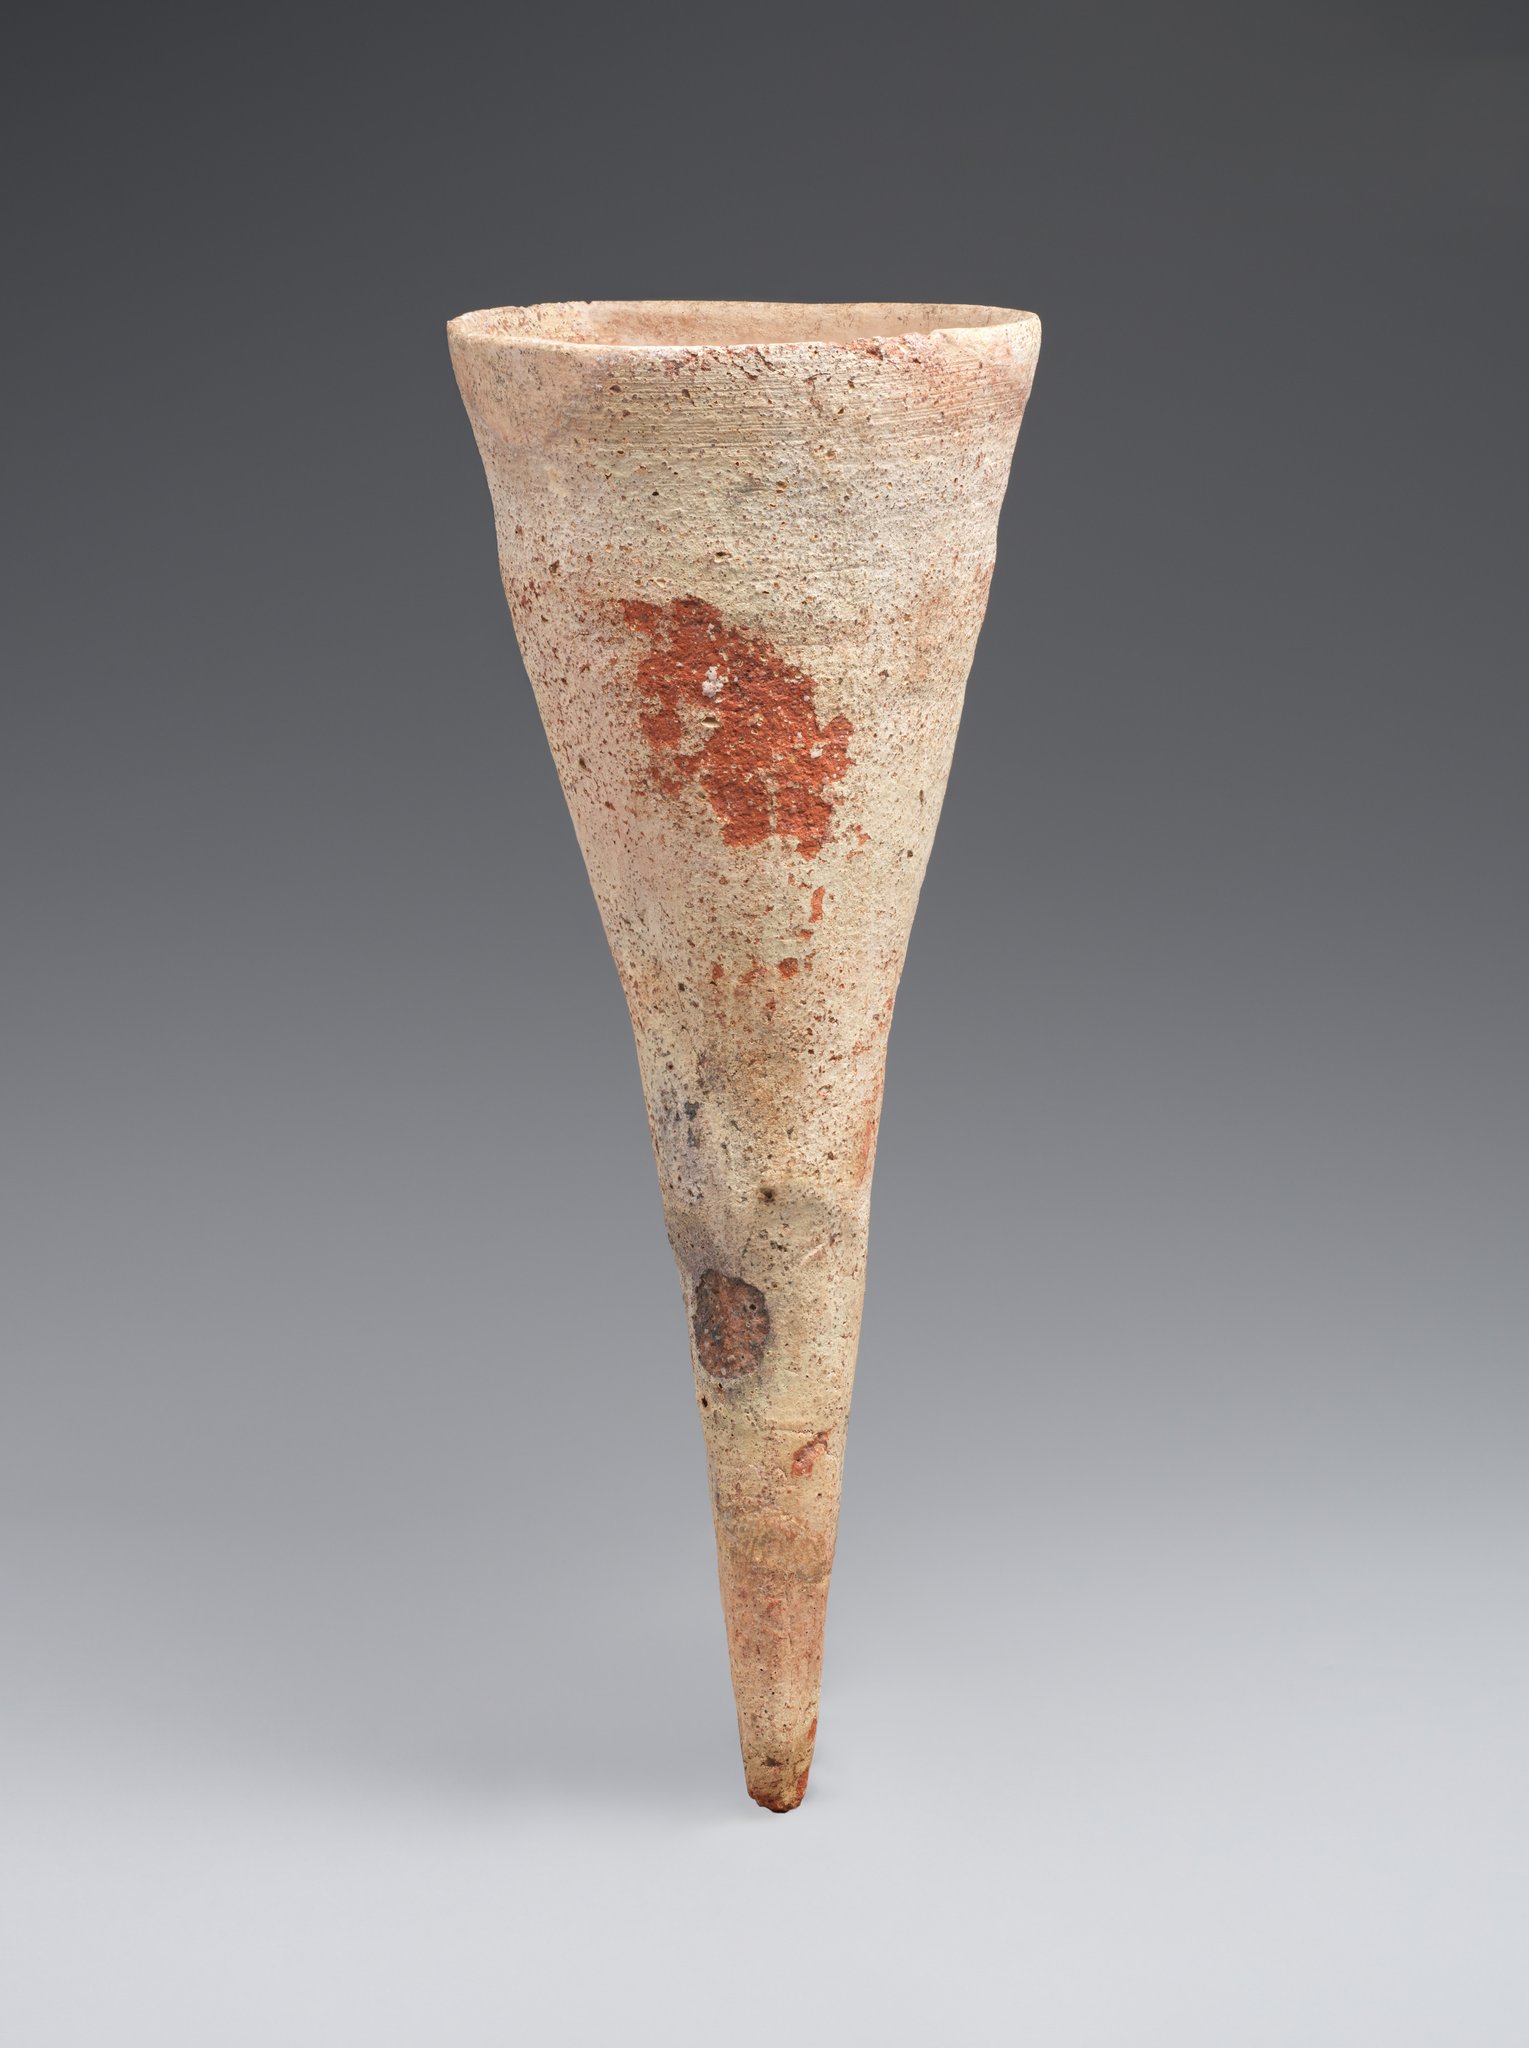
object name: cornet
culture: ghassulian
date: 4600-3600 BCE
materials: ceramic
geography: levant